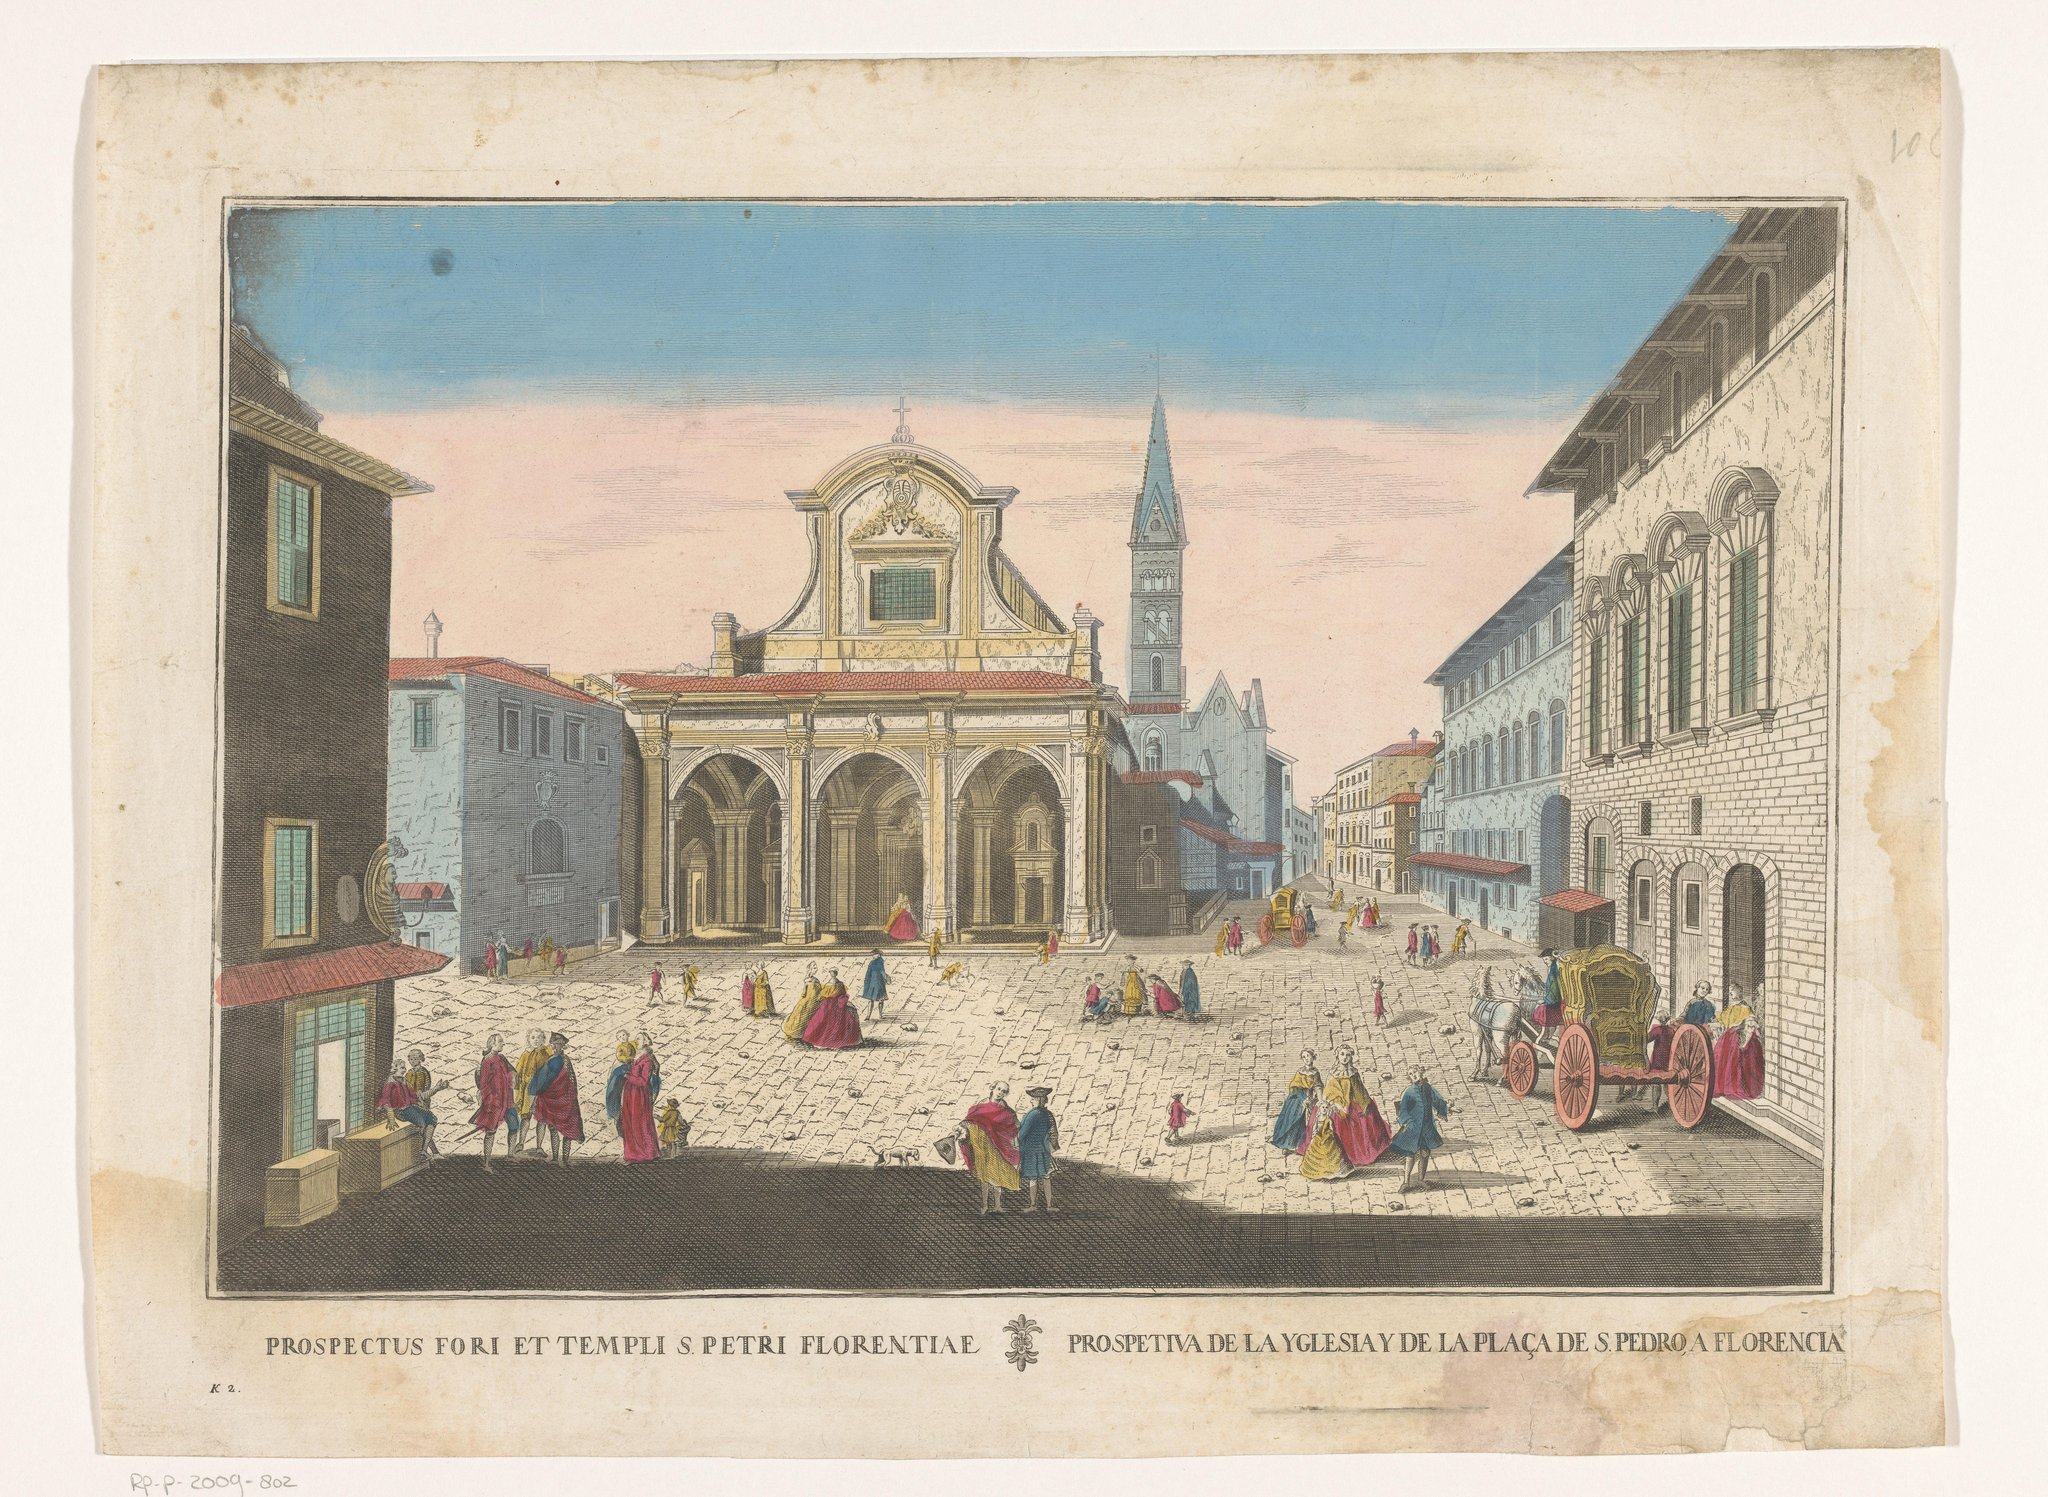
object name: print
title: Prospectus Fori et Templi S. Petri Florentiae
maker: Anonymous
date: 1700-1799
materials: paper, watercolor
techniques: brush, etching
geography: italy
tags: florence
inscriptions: watermark, collector's mark: Lugt 2228